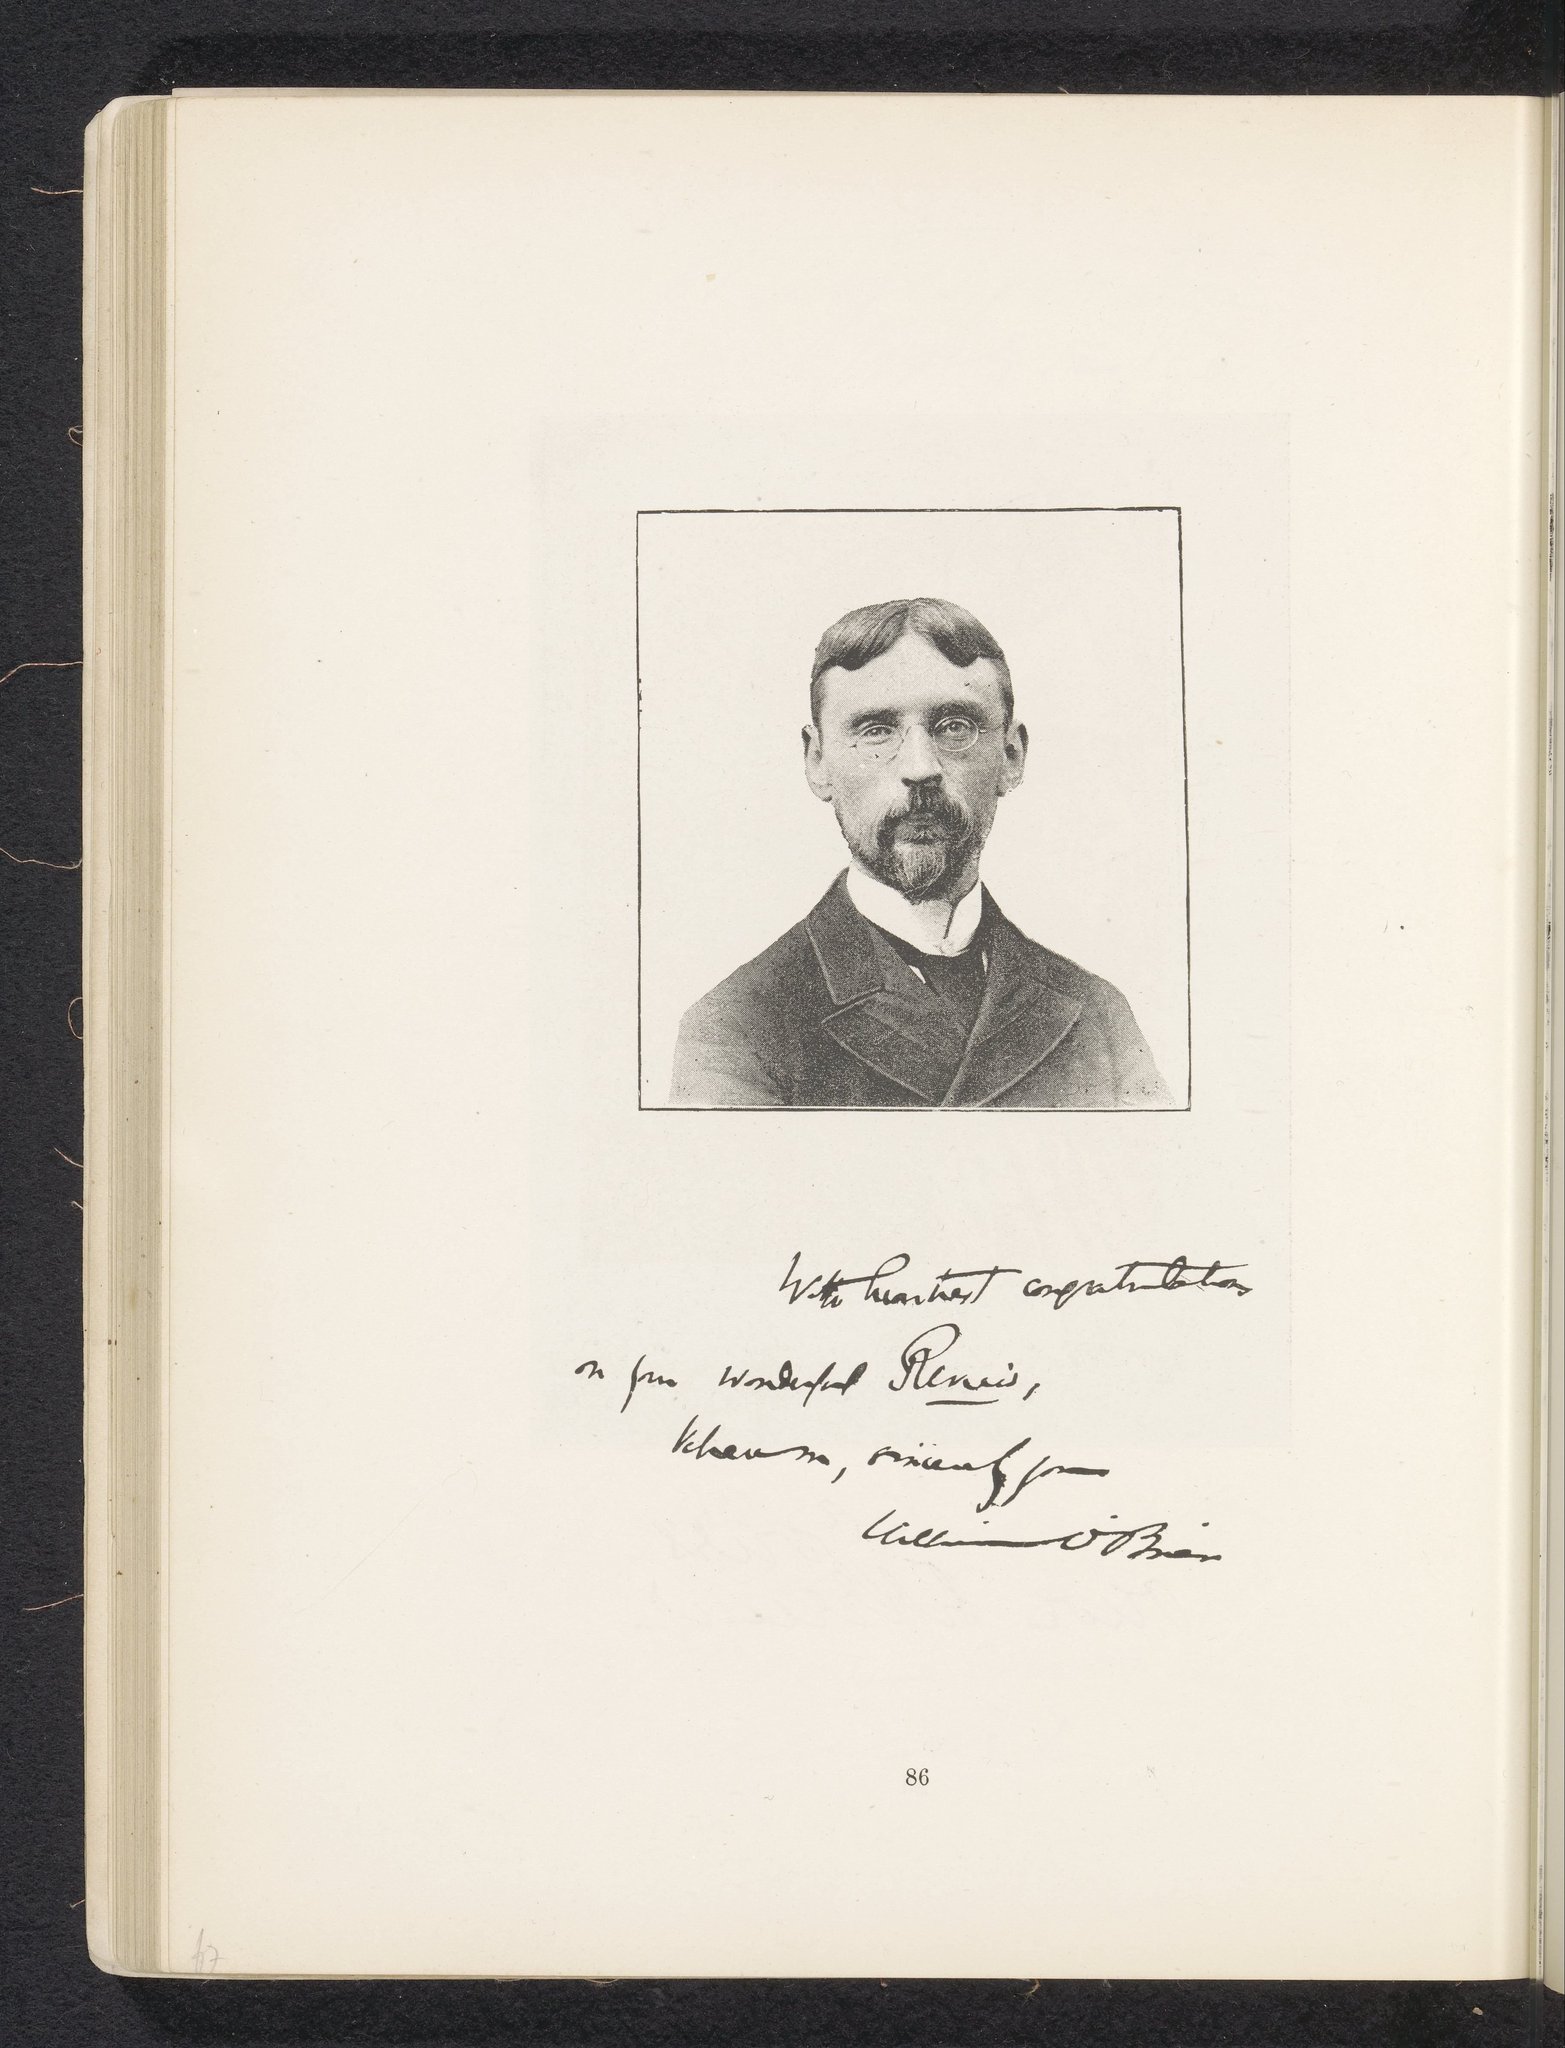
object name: page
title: Portret van William O'Brien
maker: Anonymous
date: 1881-1891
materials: paper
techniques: autotype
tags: portrait of a writer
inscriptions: inscription